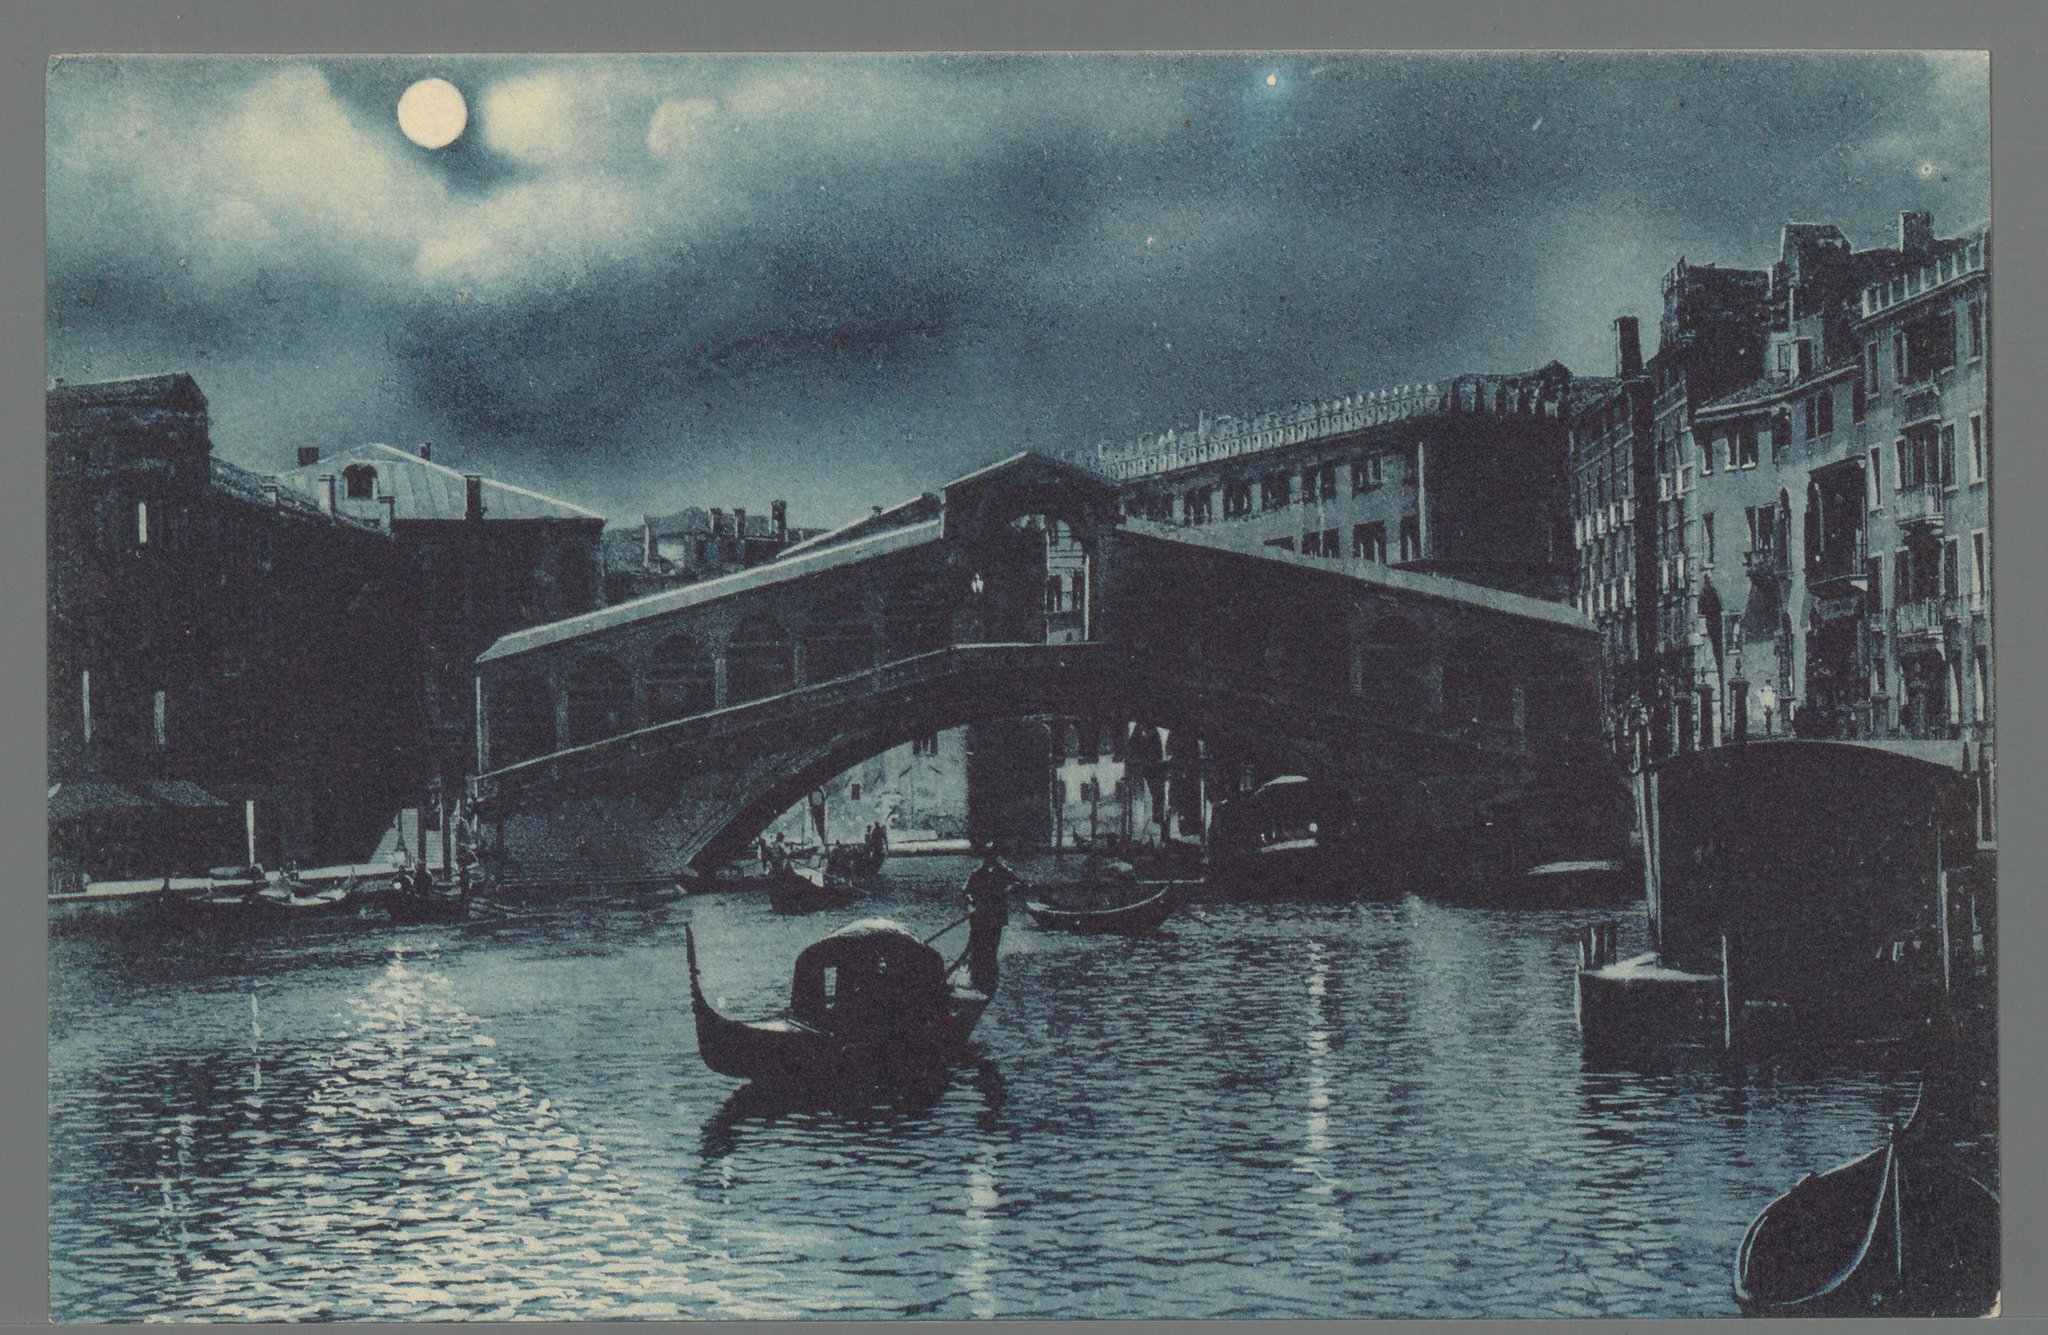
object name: photomechanical print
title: Venezia. Ponte di Rialto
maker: Anonymous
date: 1900-1905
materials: cardboard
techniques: photograph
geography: venice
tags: bridge in city with structures, i.e. shops, houses, e.g. ponte vecchio in florence (+ city(-scape) with figures, staffage), moonlight, canal